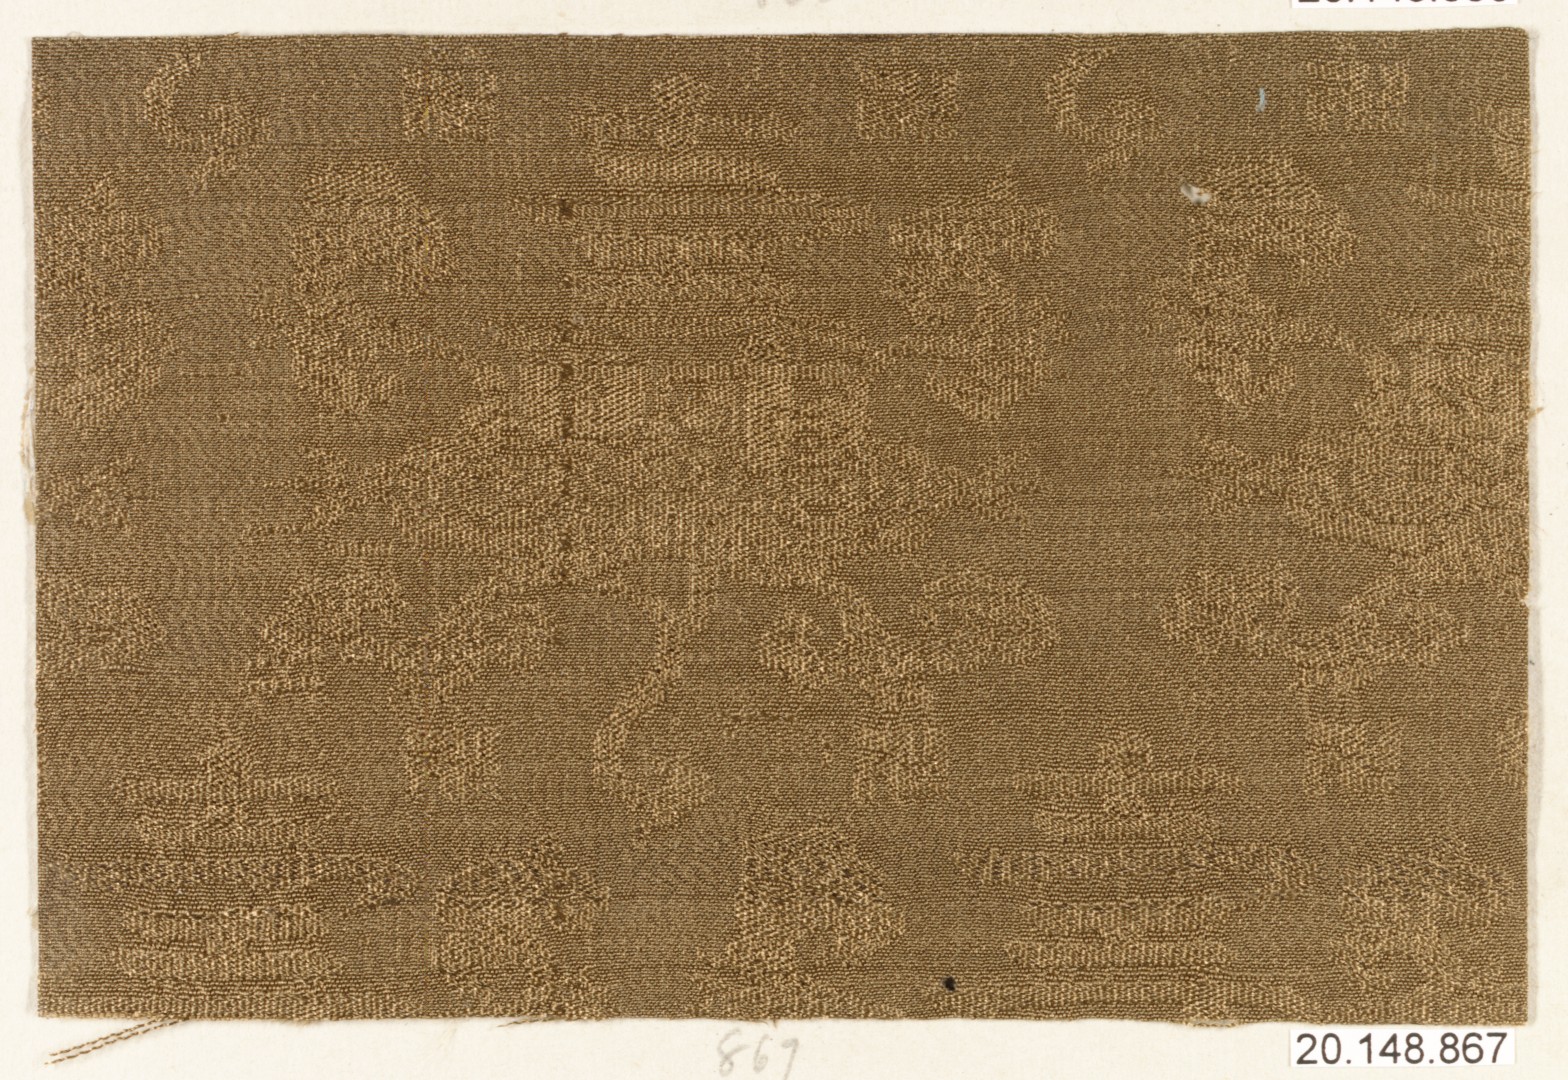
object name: piece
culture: japanese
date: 1601-1700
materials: silk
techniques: compound weave